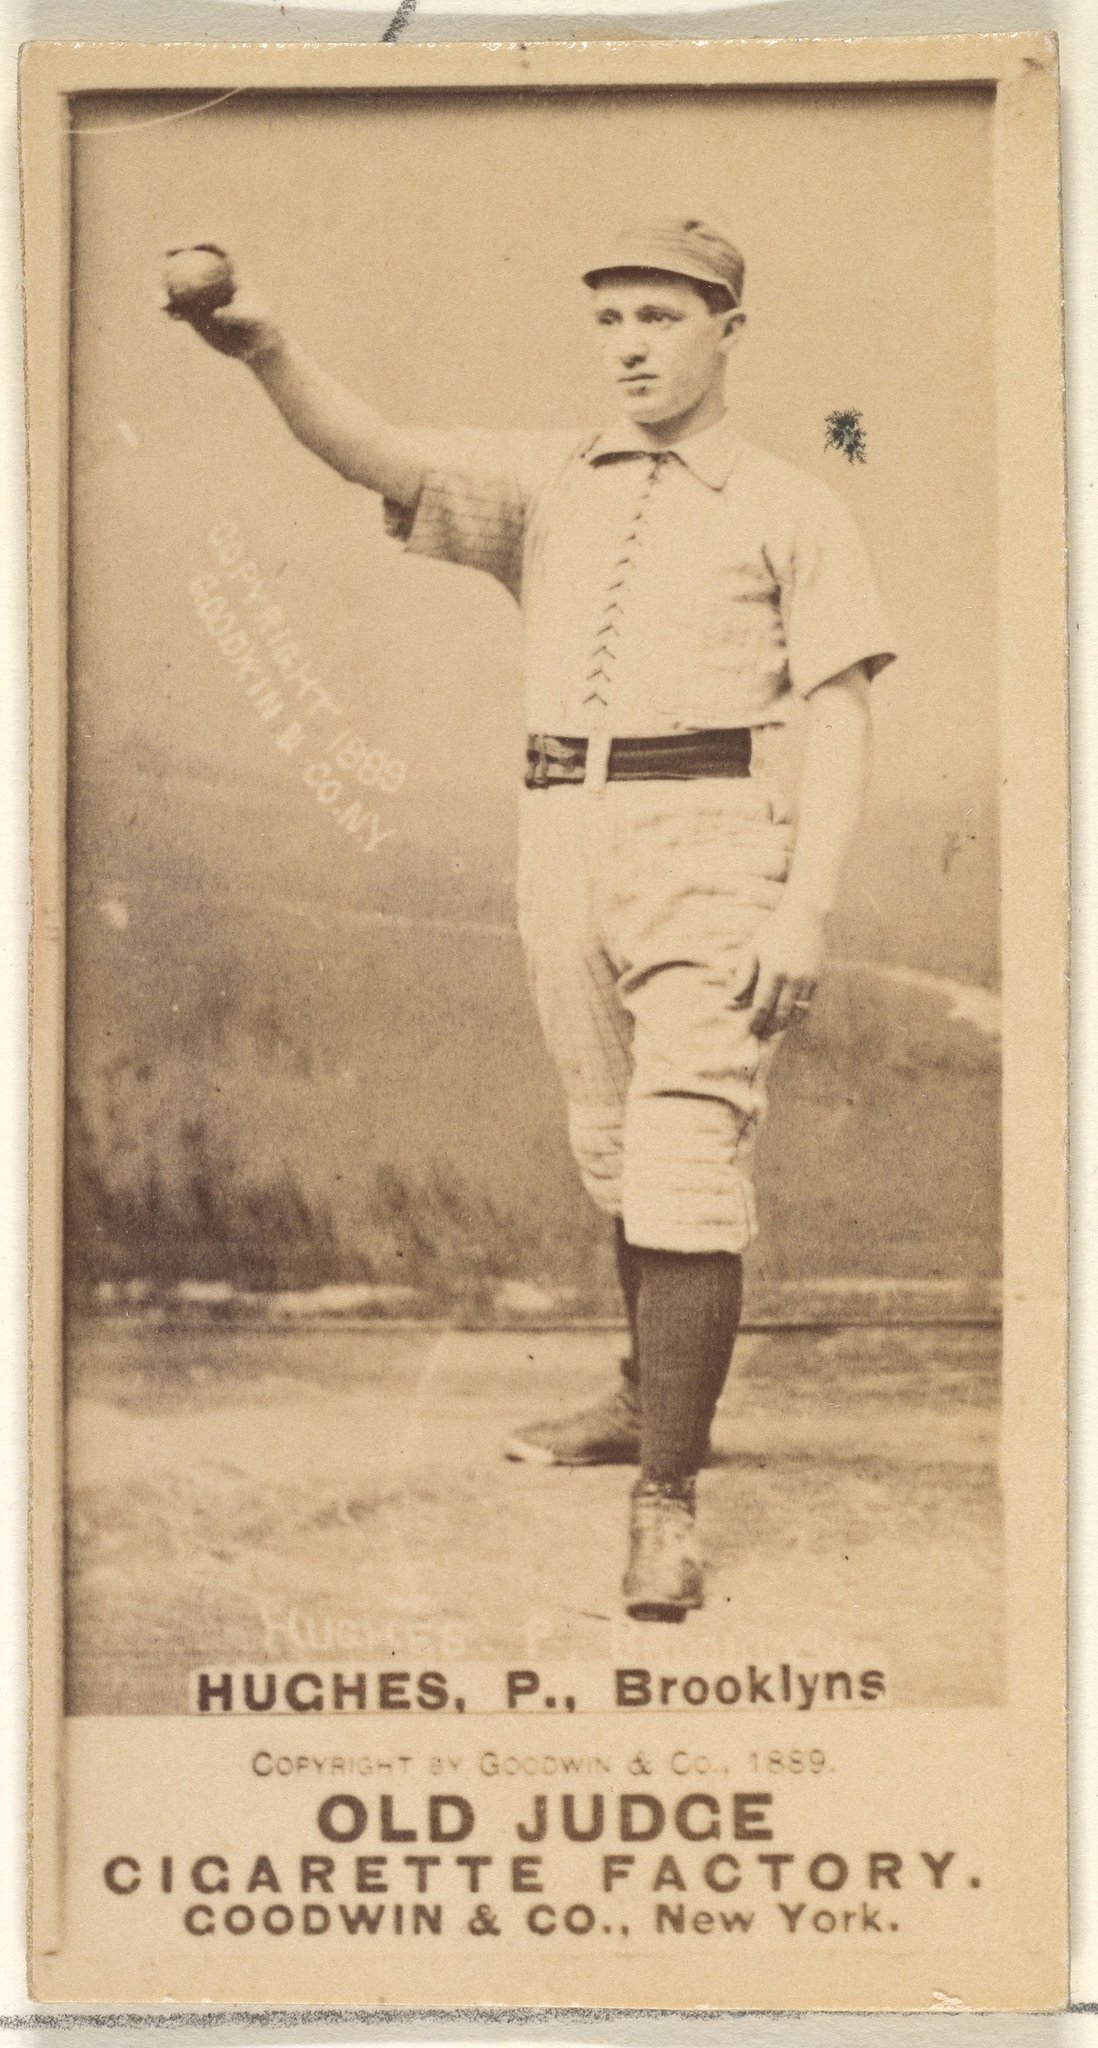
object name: baseball card, photograph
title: Hughes, Pitcher, Brooklyn Bridegrooms, from the Old Judge series (N172) for Old Judge Cigarettes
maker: goodwin & company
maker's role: publisher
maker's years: 1850-1950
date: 1889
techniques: albumen silver print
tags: men,portraits,baseball,athletes